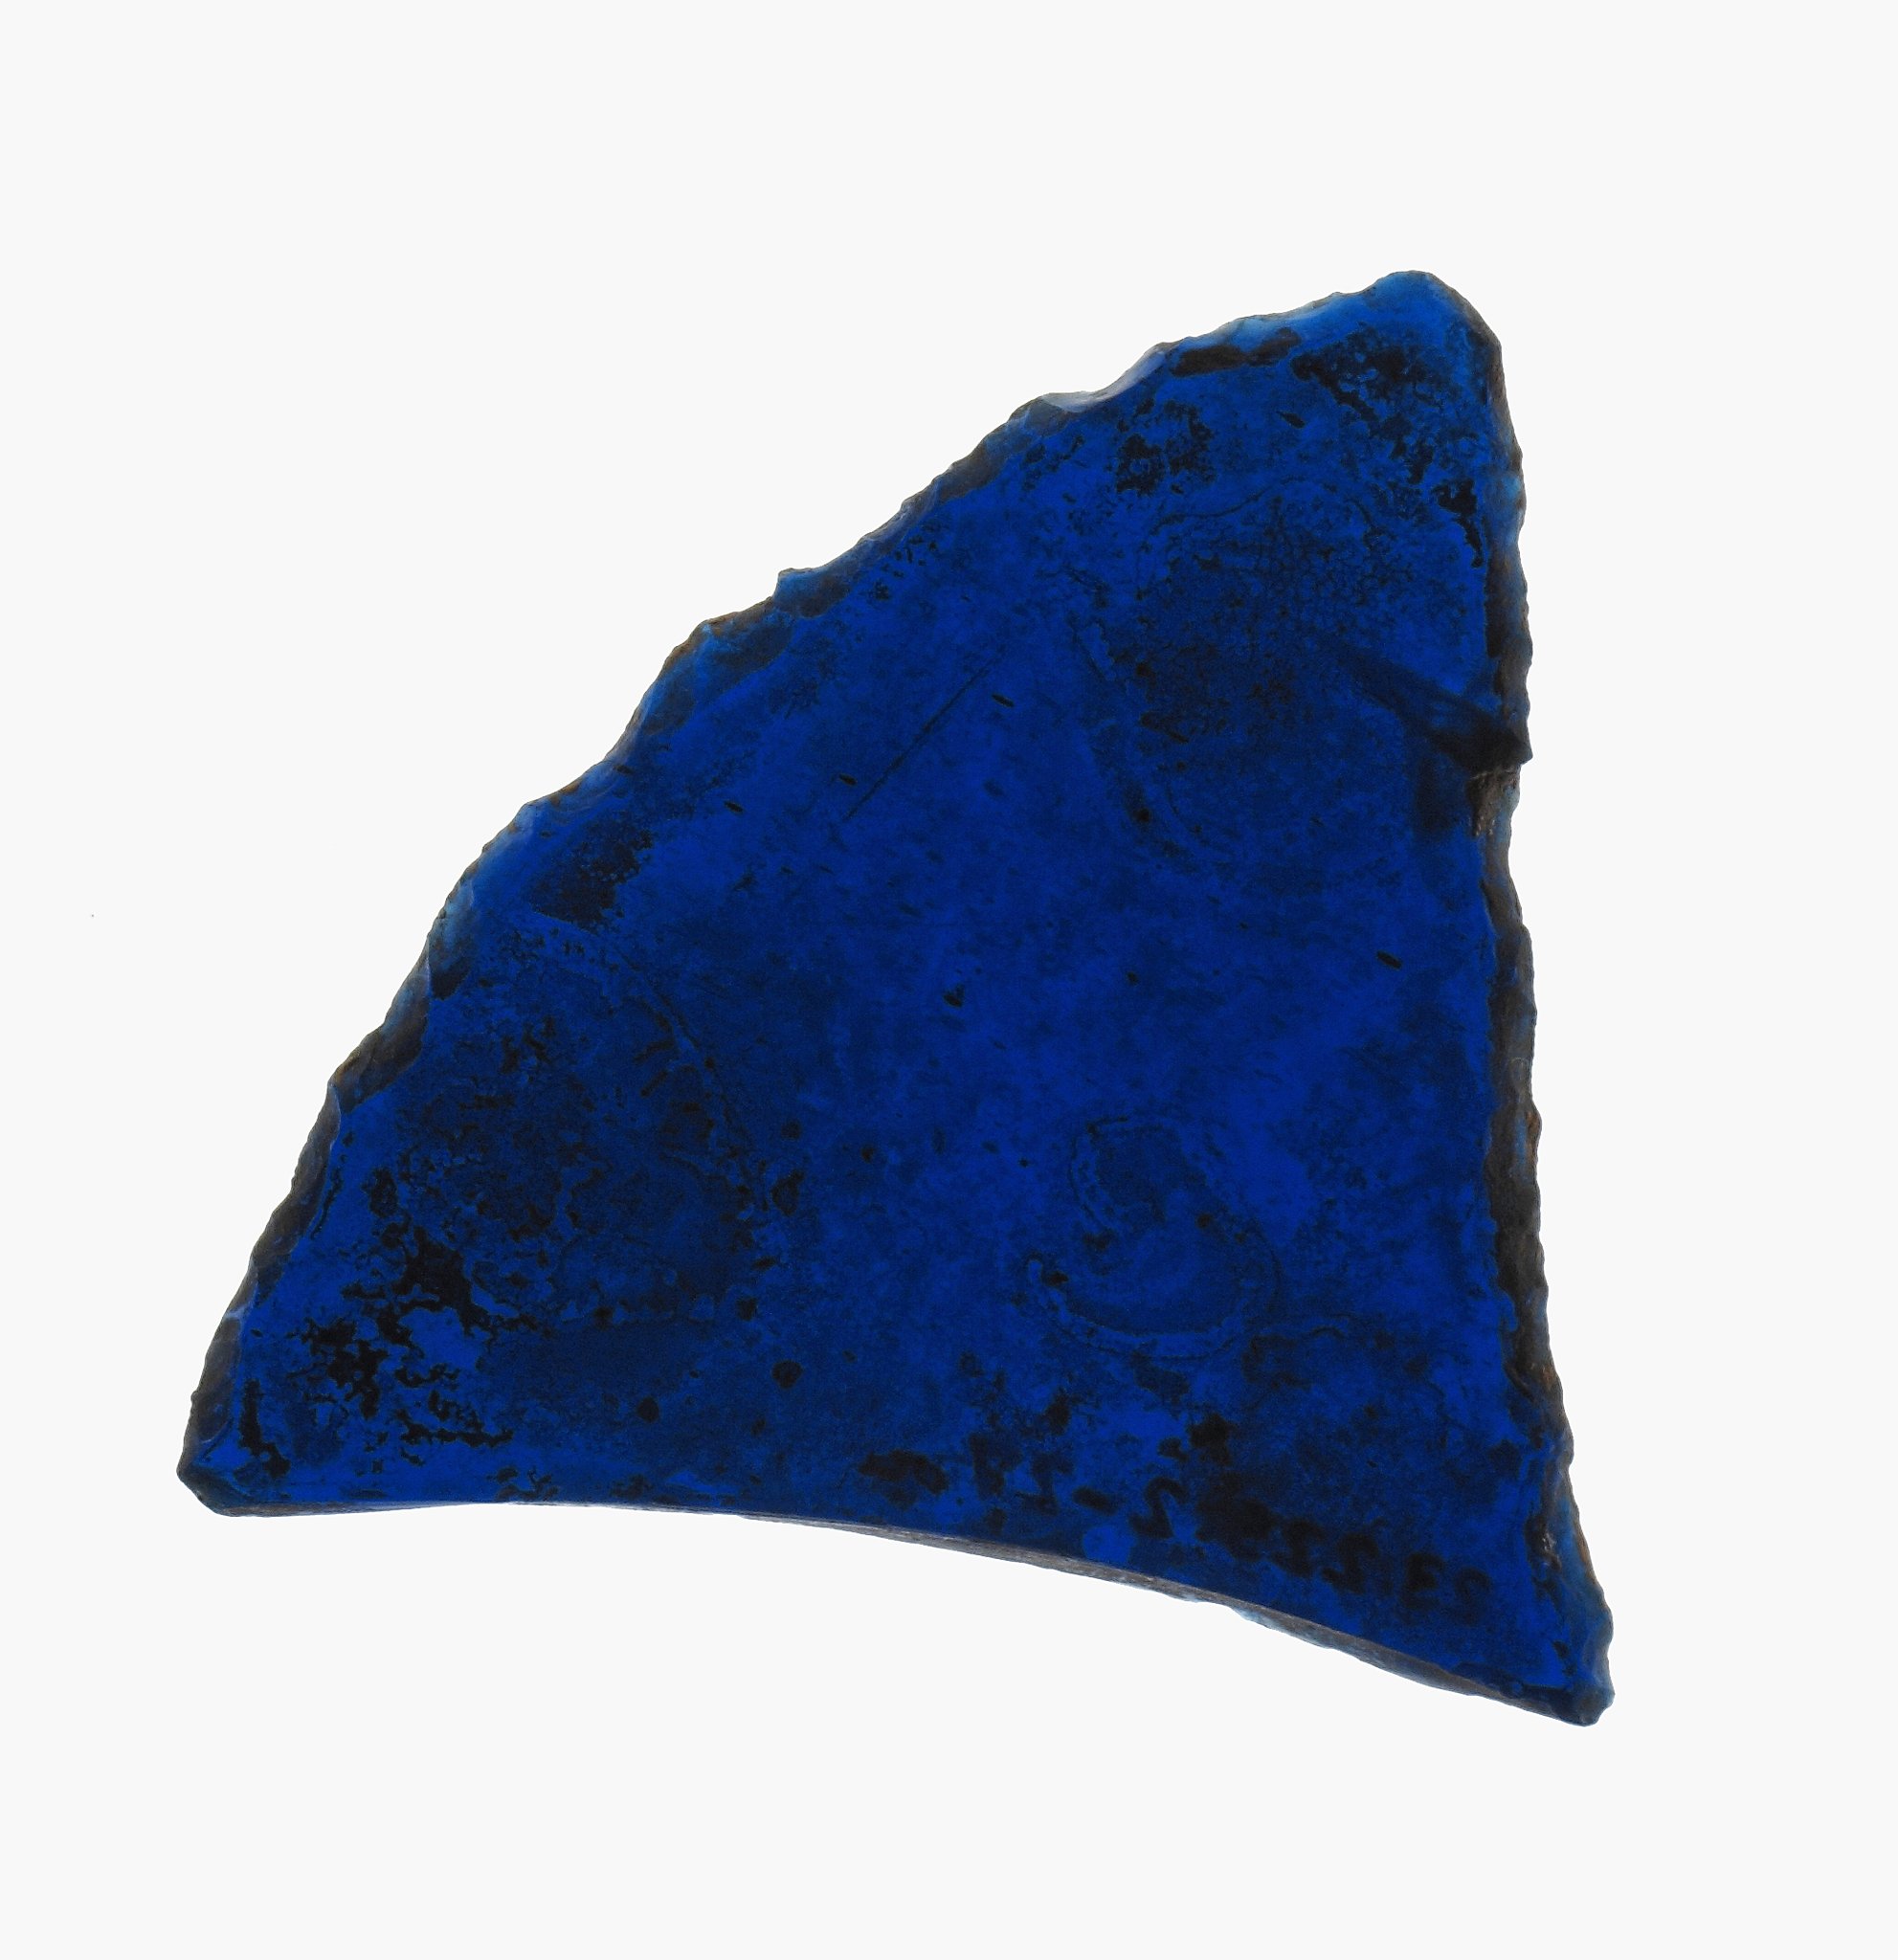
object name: fragment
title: Glass Fragment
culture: french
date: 1201-1300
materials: glass, metal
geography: france